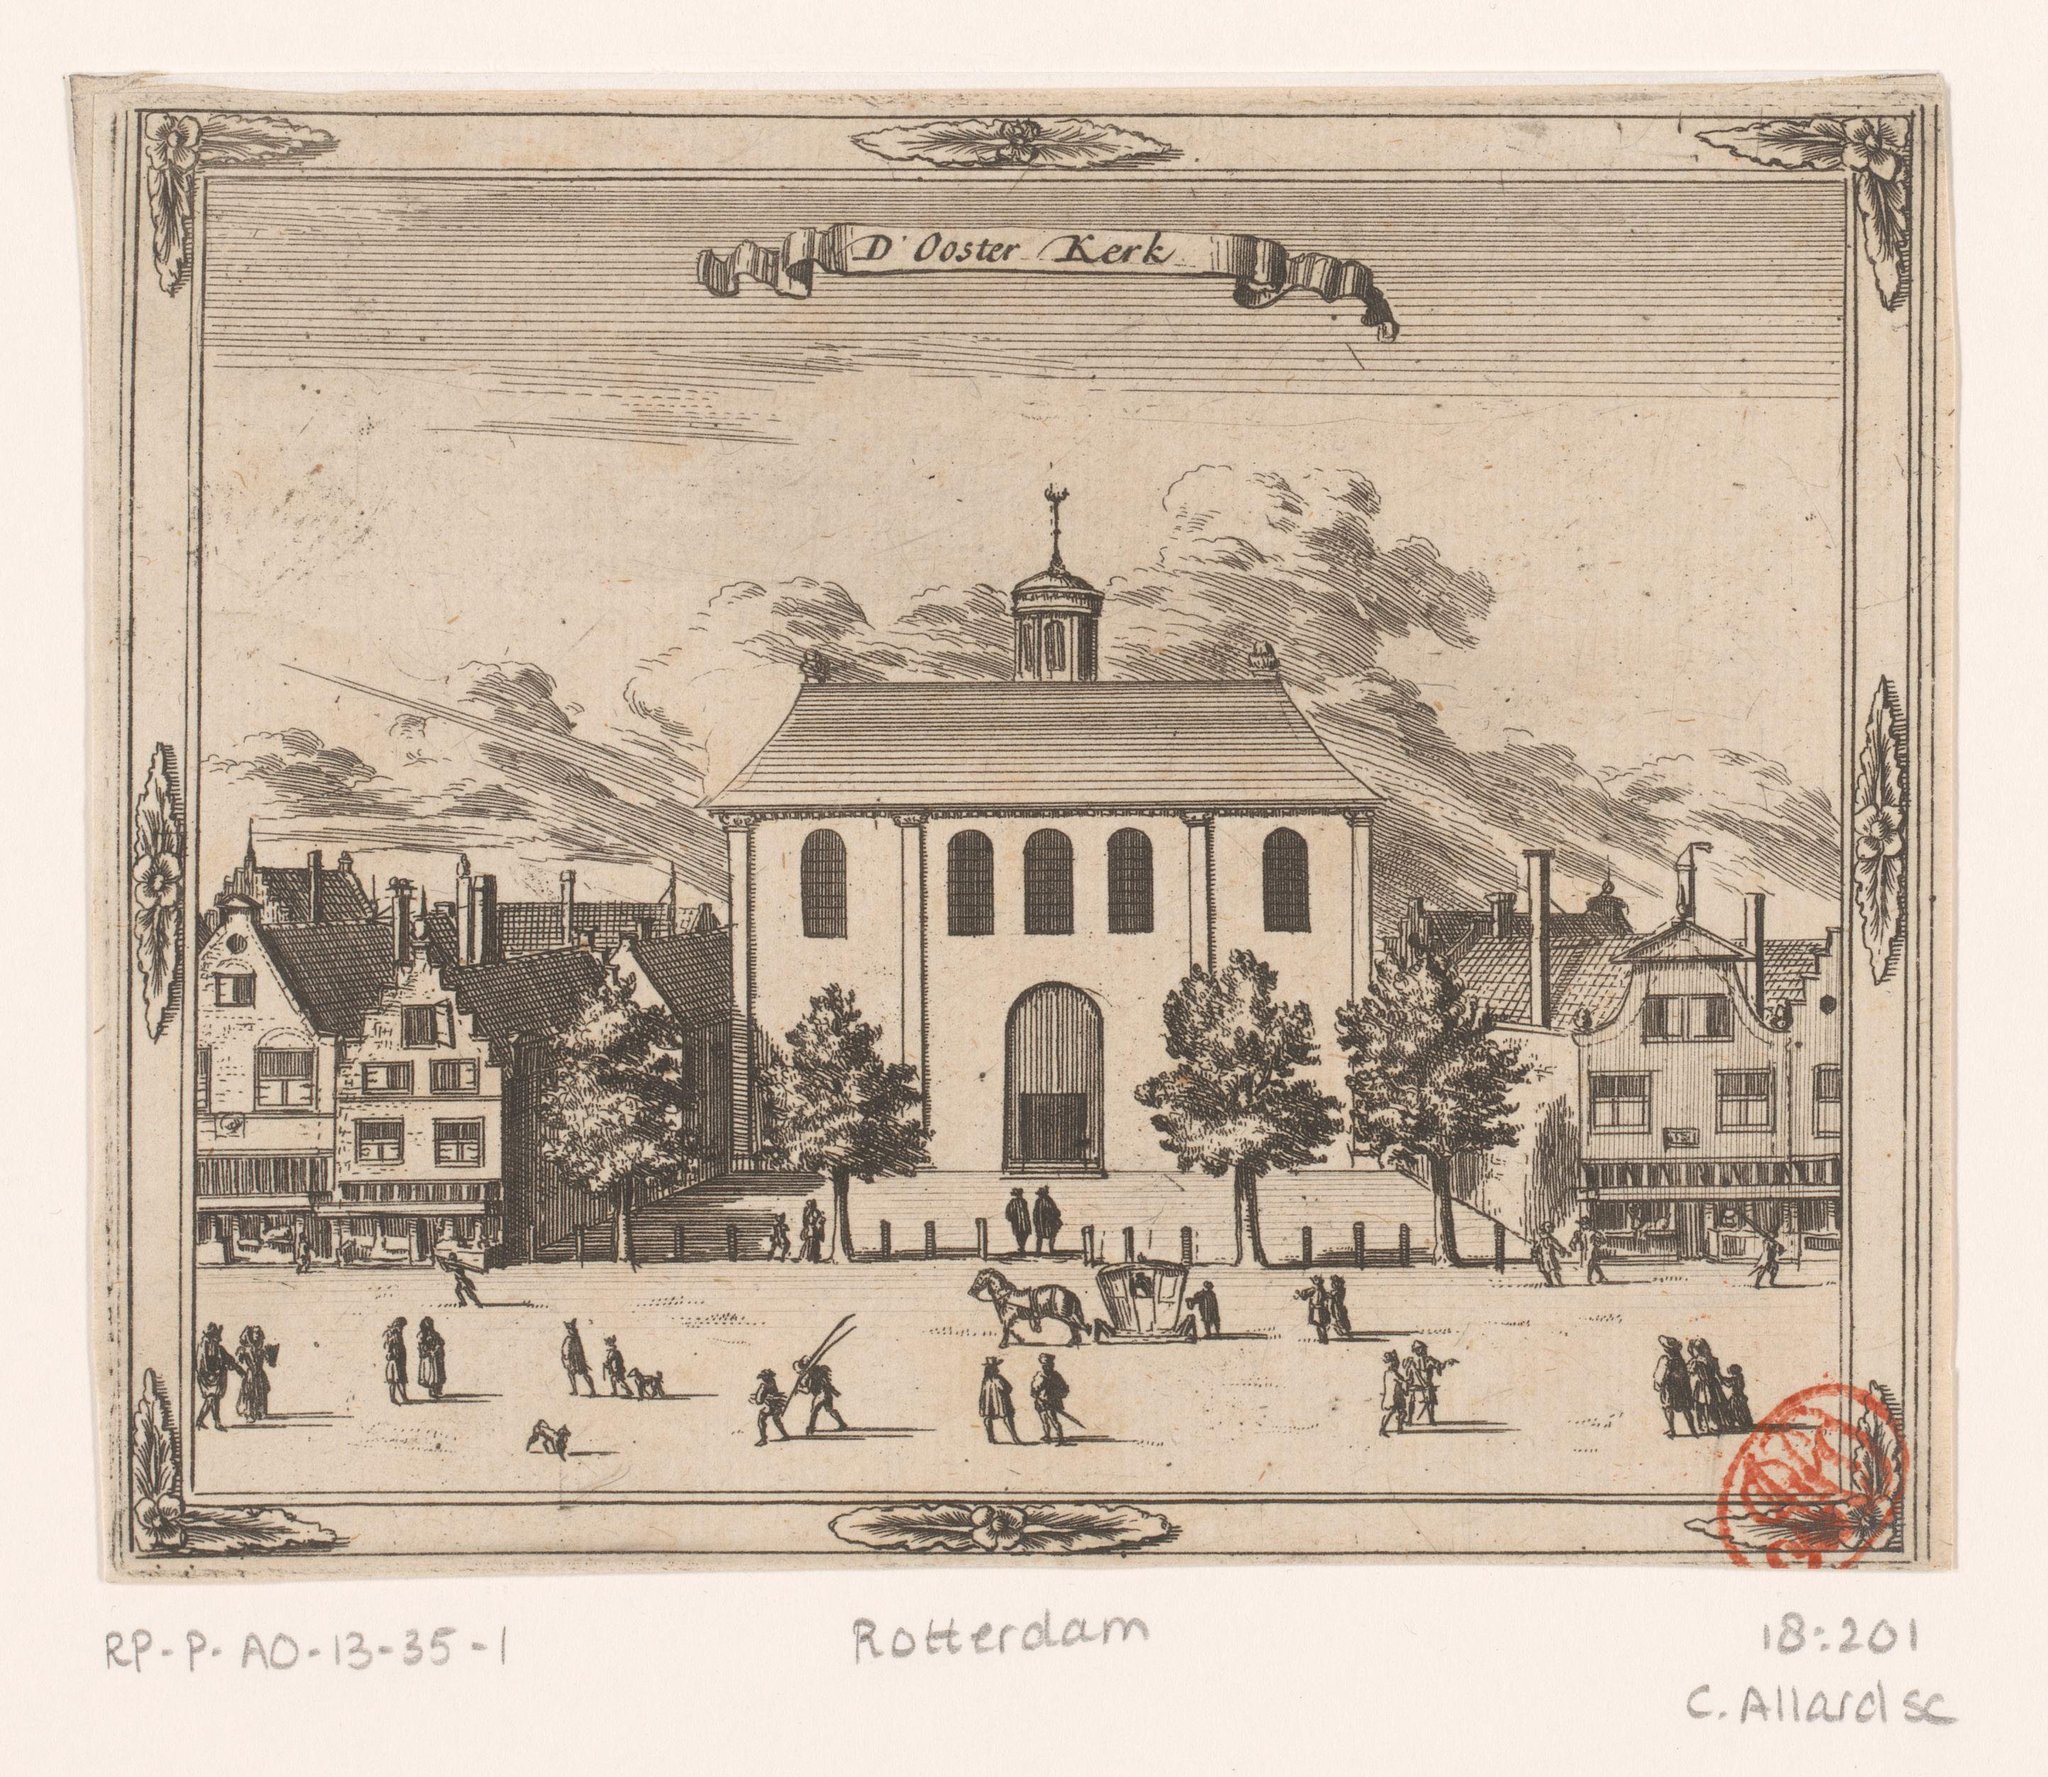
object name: print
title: Gezicht op de Oosterkerk te Rotterdam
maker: jacobus harrewijn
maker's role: print maker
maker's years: 1660-1740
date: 1715-1730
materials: paper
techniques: etching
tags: church (exterior), street (+ city(-scape) with figures, staffage)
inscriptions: collector's mark: Lugt 2228, collector's mark: Lugt 195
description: Prent vermoedelijk eerst met dertien andere stadsgezichten uitgegeven als onderdeel van de sierrand van – in ieder geval de derde staat en mogelijk ook de tweede van – de plattegrond 'Tabula Roterodami Novissima' (zie RP-P-AO-13-11). Later nog een keer als onderdeel van een prentserie uitgegeven: Les principaux edifices et vues de la ville de Rotterdam. Le tout fidèlement dessiné sur les lieux. Leiden: Pieter van der Aa, s.a. [adres 'dans l'Academie', dus 1715-1730]. De platen zijn voor zover na te gaan ongewijzigd gebleven.